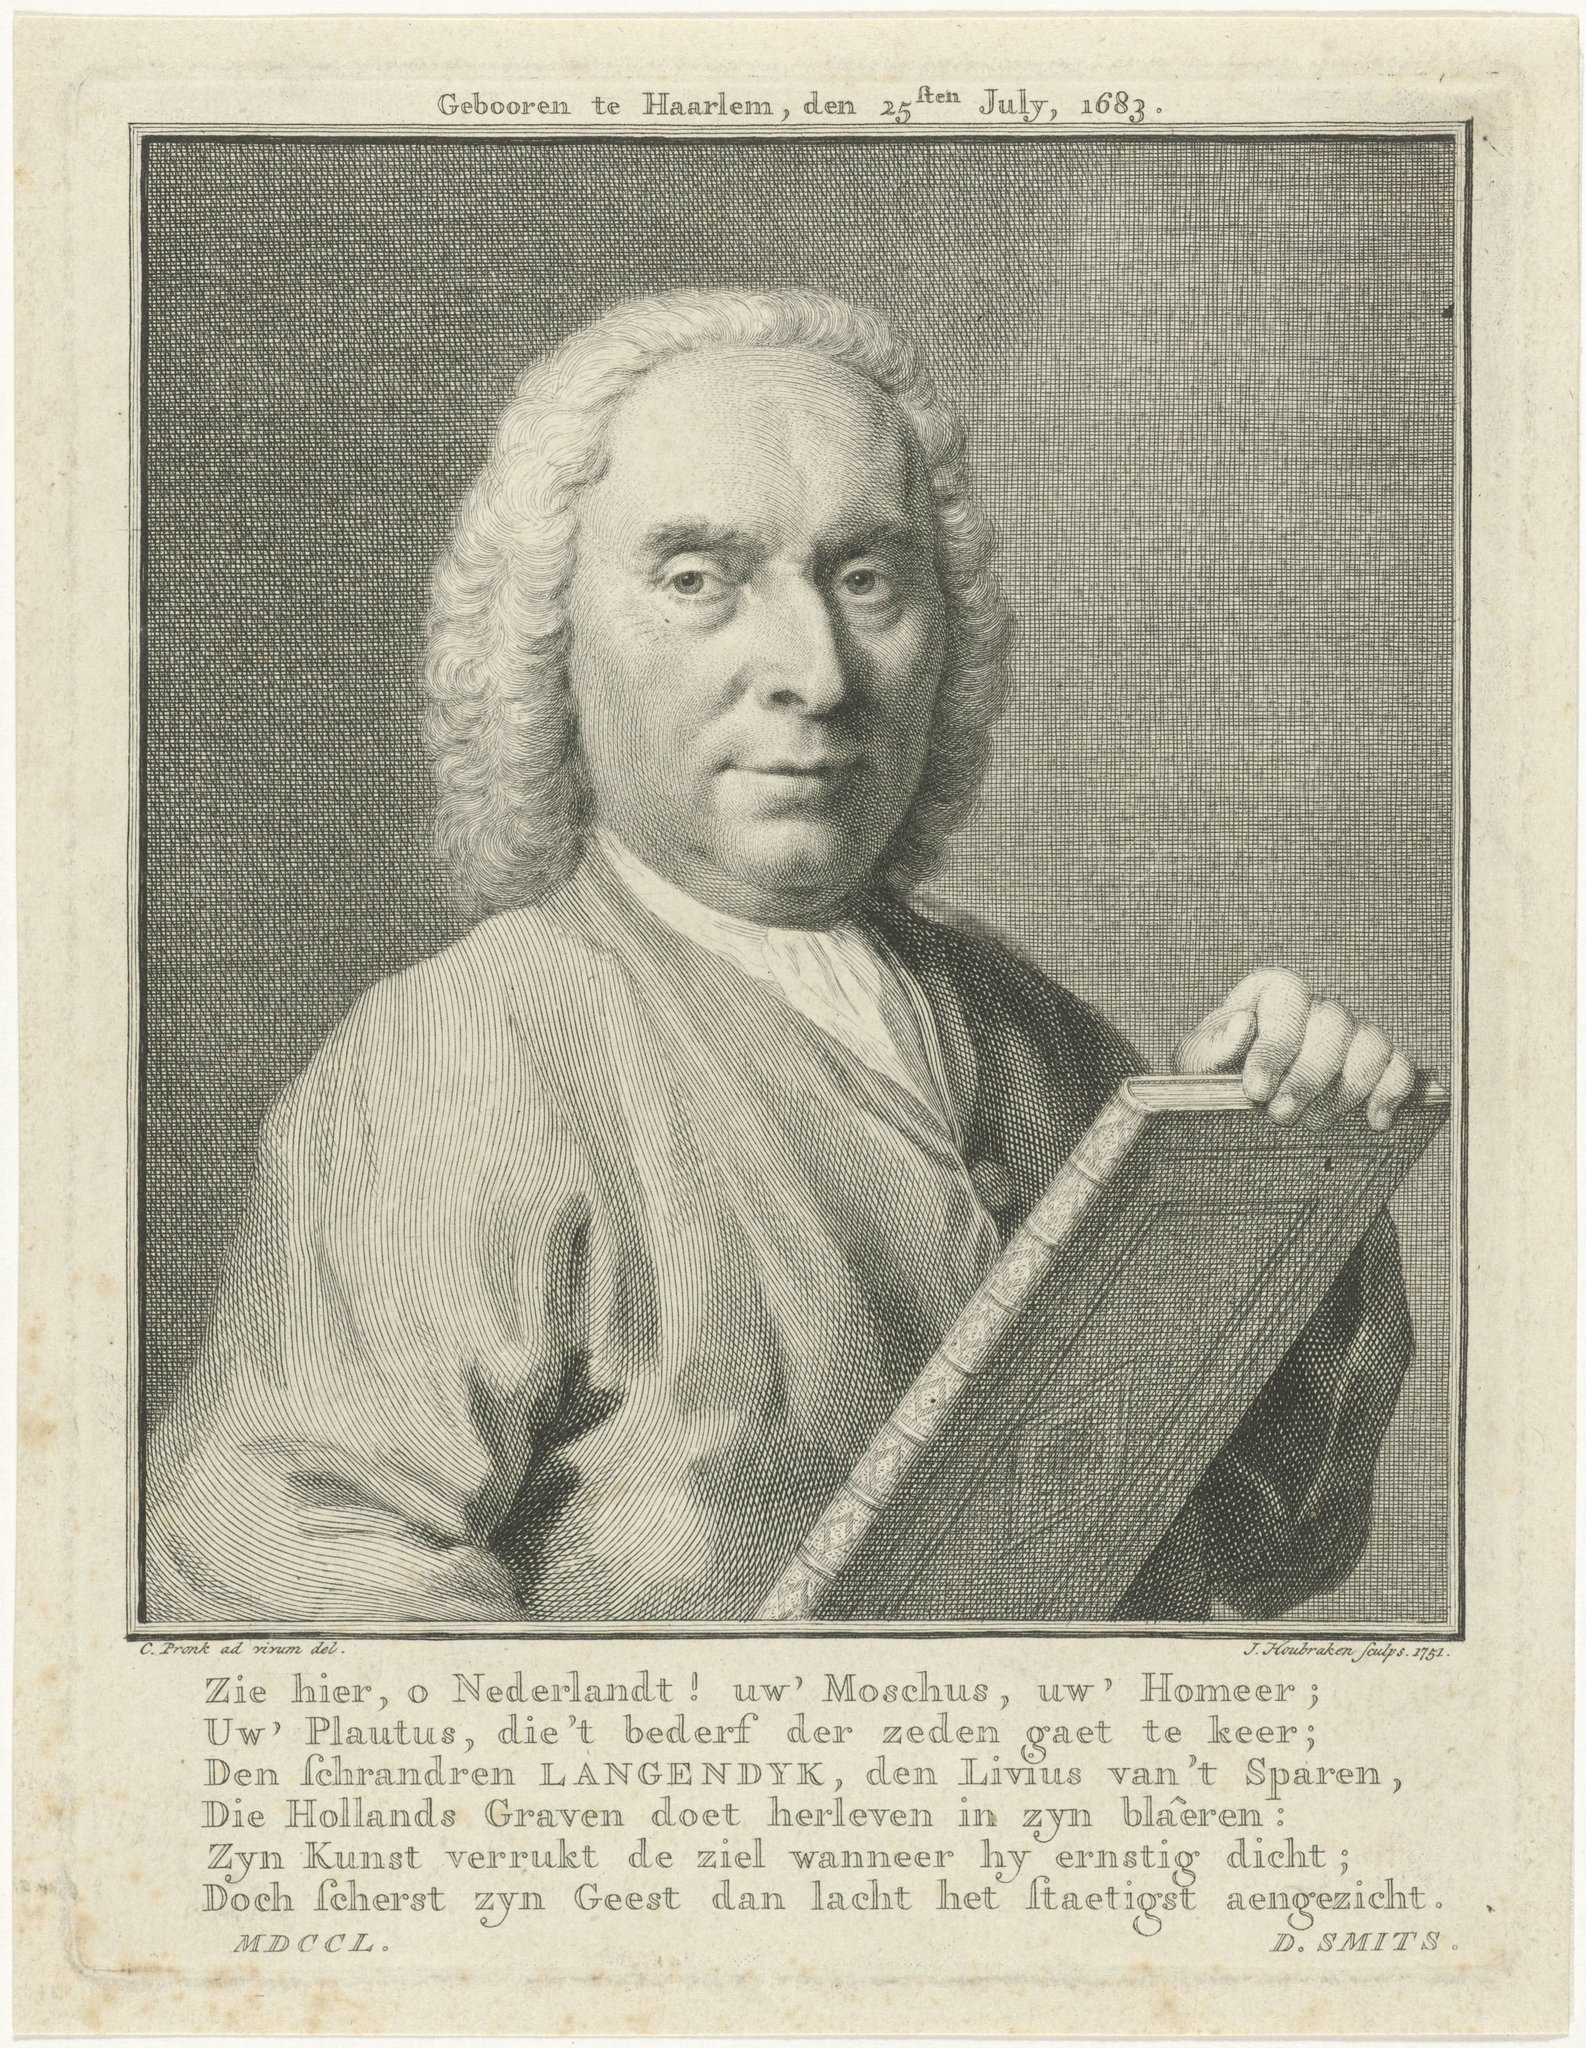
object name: print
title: Portret van Pieter Langendijk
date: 1751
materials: paper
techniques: engraving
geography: amsterdam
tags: print maker, pieter langendijk (i)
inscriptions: collector's mark: Lugt 2228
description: Portret naar rechts van Pieter Langendijk met in zijn hand een boek. Onder het portret een zesregelig vers in het Nederlands. Bovenaan zijn geboortegegevens in een regel in het Nederlands.